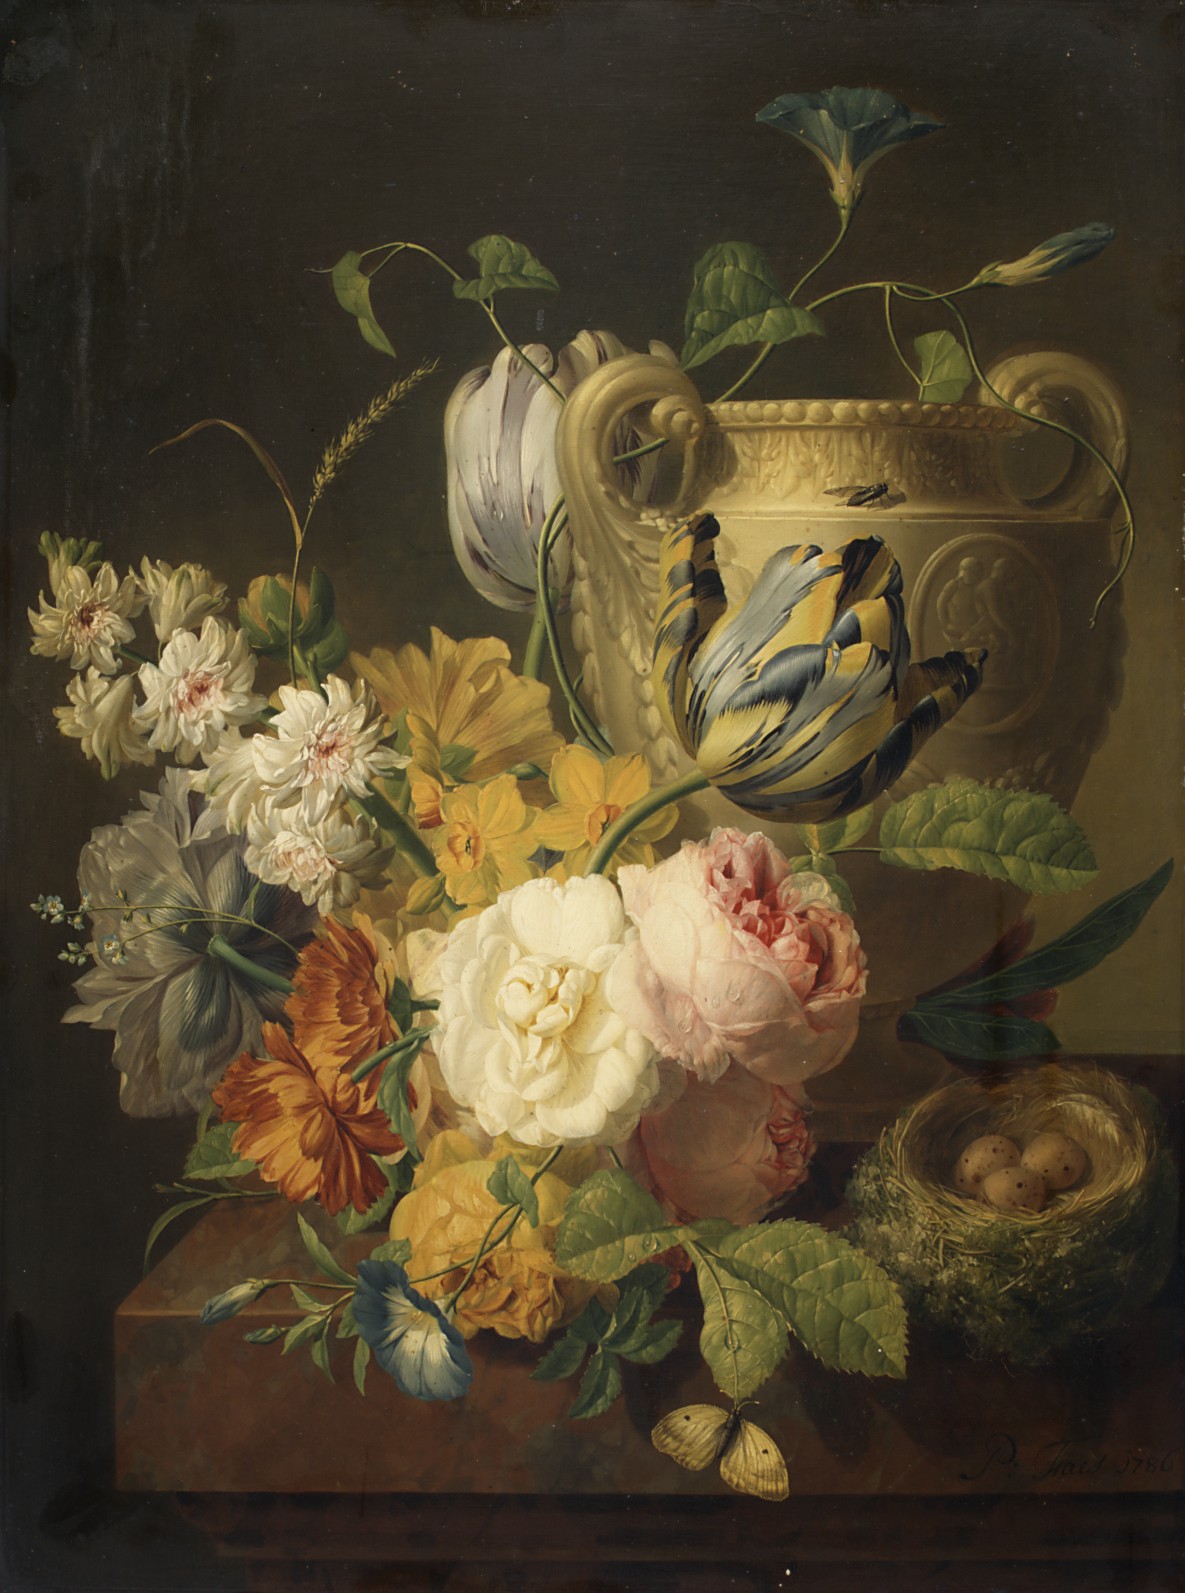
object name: painting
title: Flowers by a Stone Vase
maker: peter faes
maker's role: artist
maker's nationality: flemish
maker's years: 1750-1814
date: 1786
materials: oil, wood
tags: flowers,still life,vases